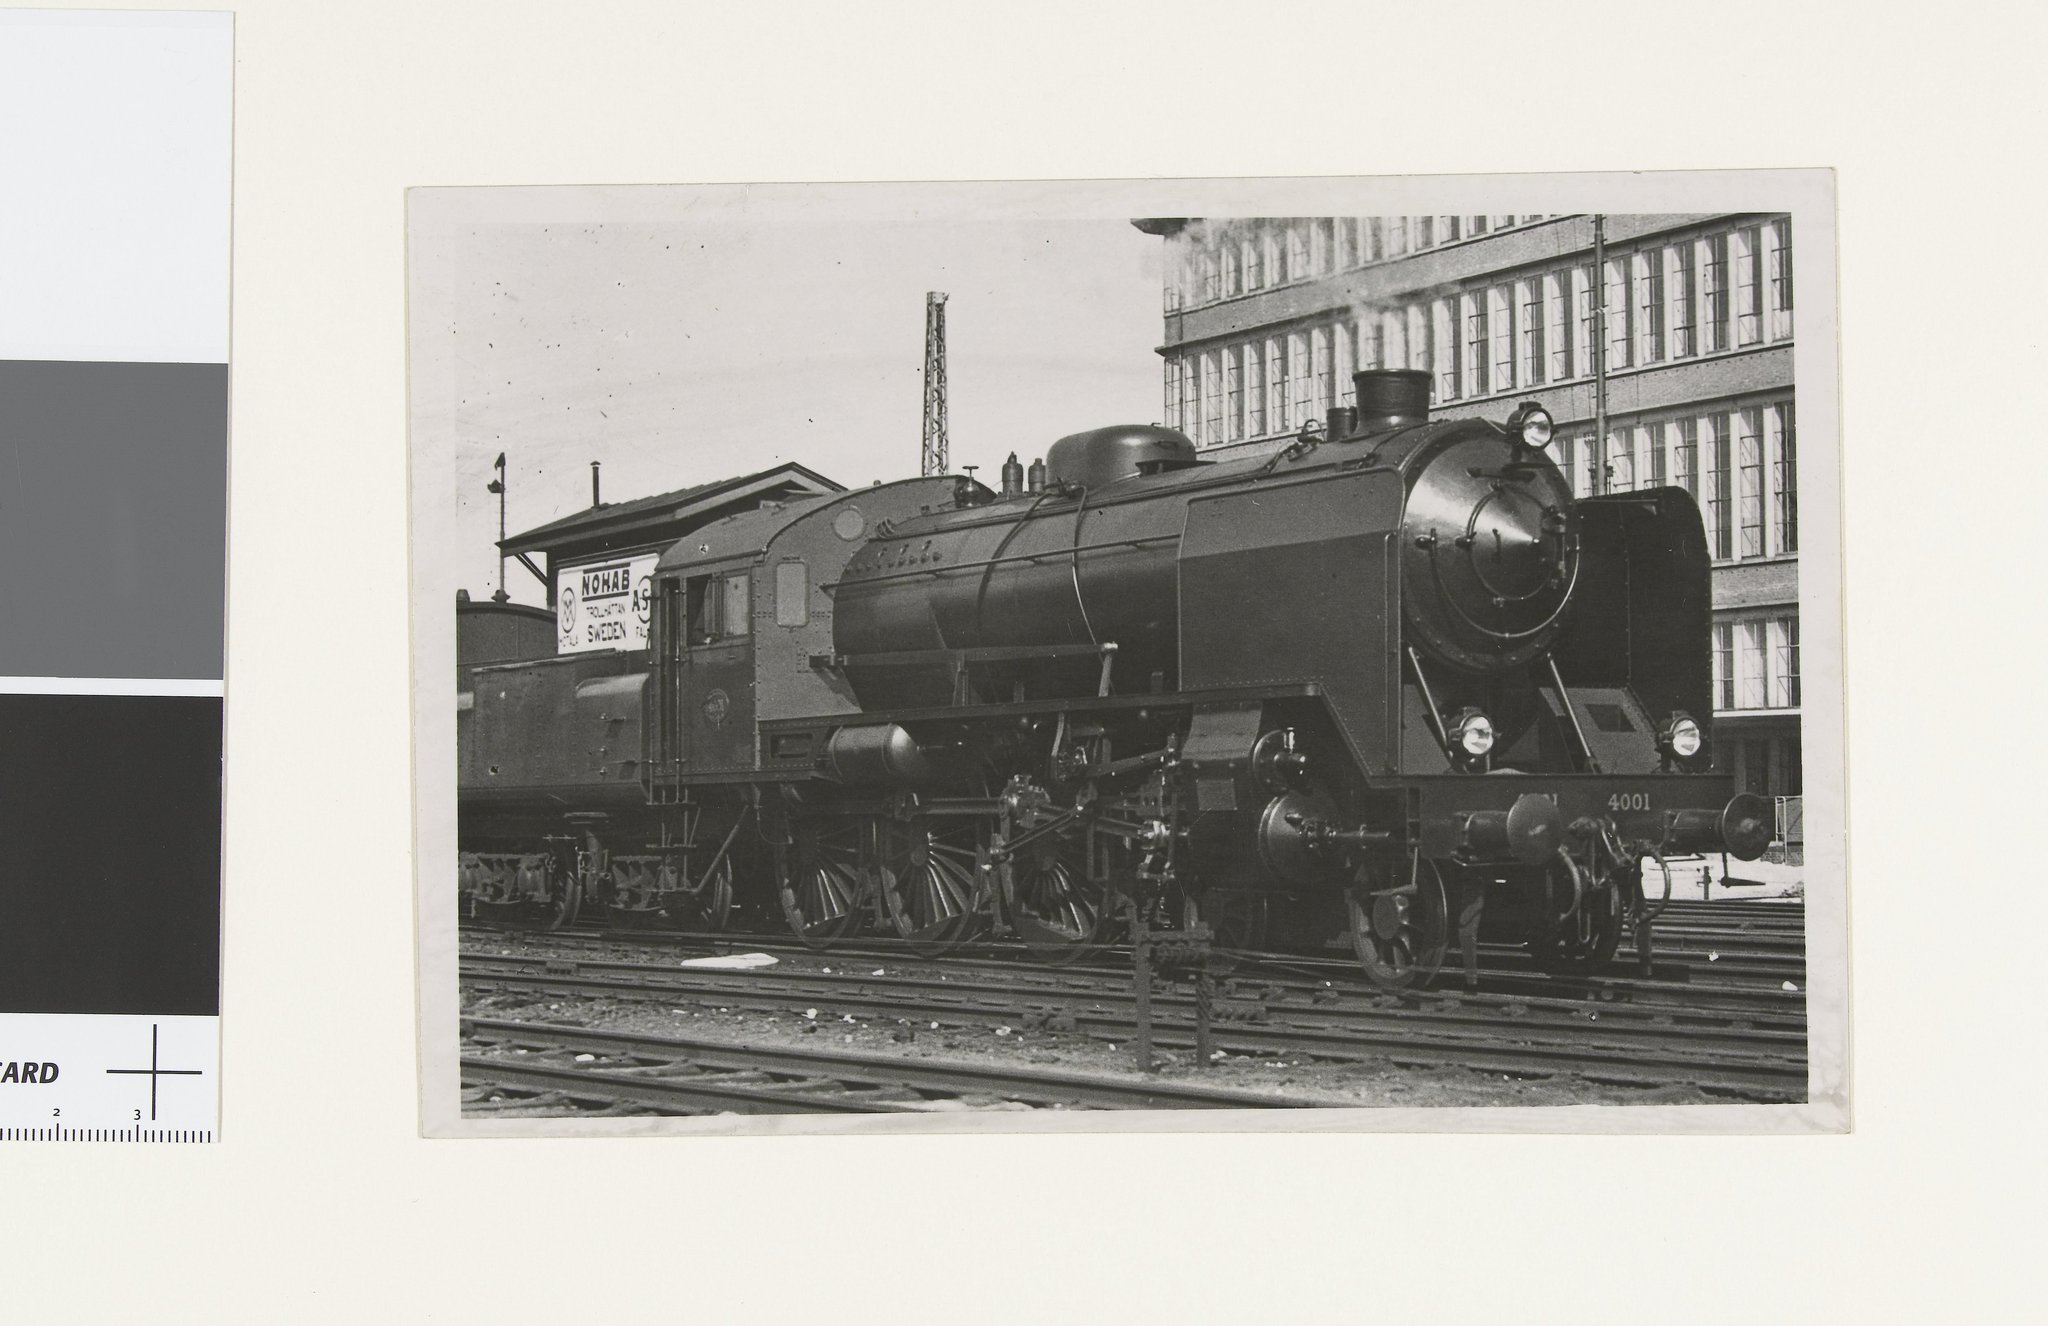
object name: documentary photograph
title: Nieuwe sneltreinlocomotief uit Zweden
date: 1946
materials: photographic support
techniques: photography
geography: utrecht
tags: utrecht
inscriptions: number: ‘15771’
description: De nieuwe aanwinst van de NS, een sneltreinlocomotief uit Zweden, staat gereed voor een proefrit op het spoor te Utrecht. De locomotief is in zijn totaliteit zijwaarts gefotografeerd. Tijdens WOII was 84% van alle locomotieven geroofd en ongeveer 95% van alle goederen- en personenwagons.